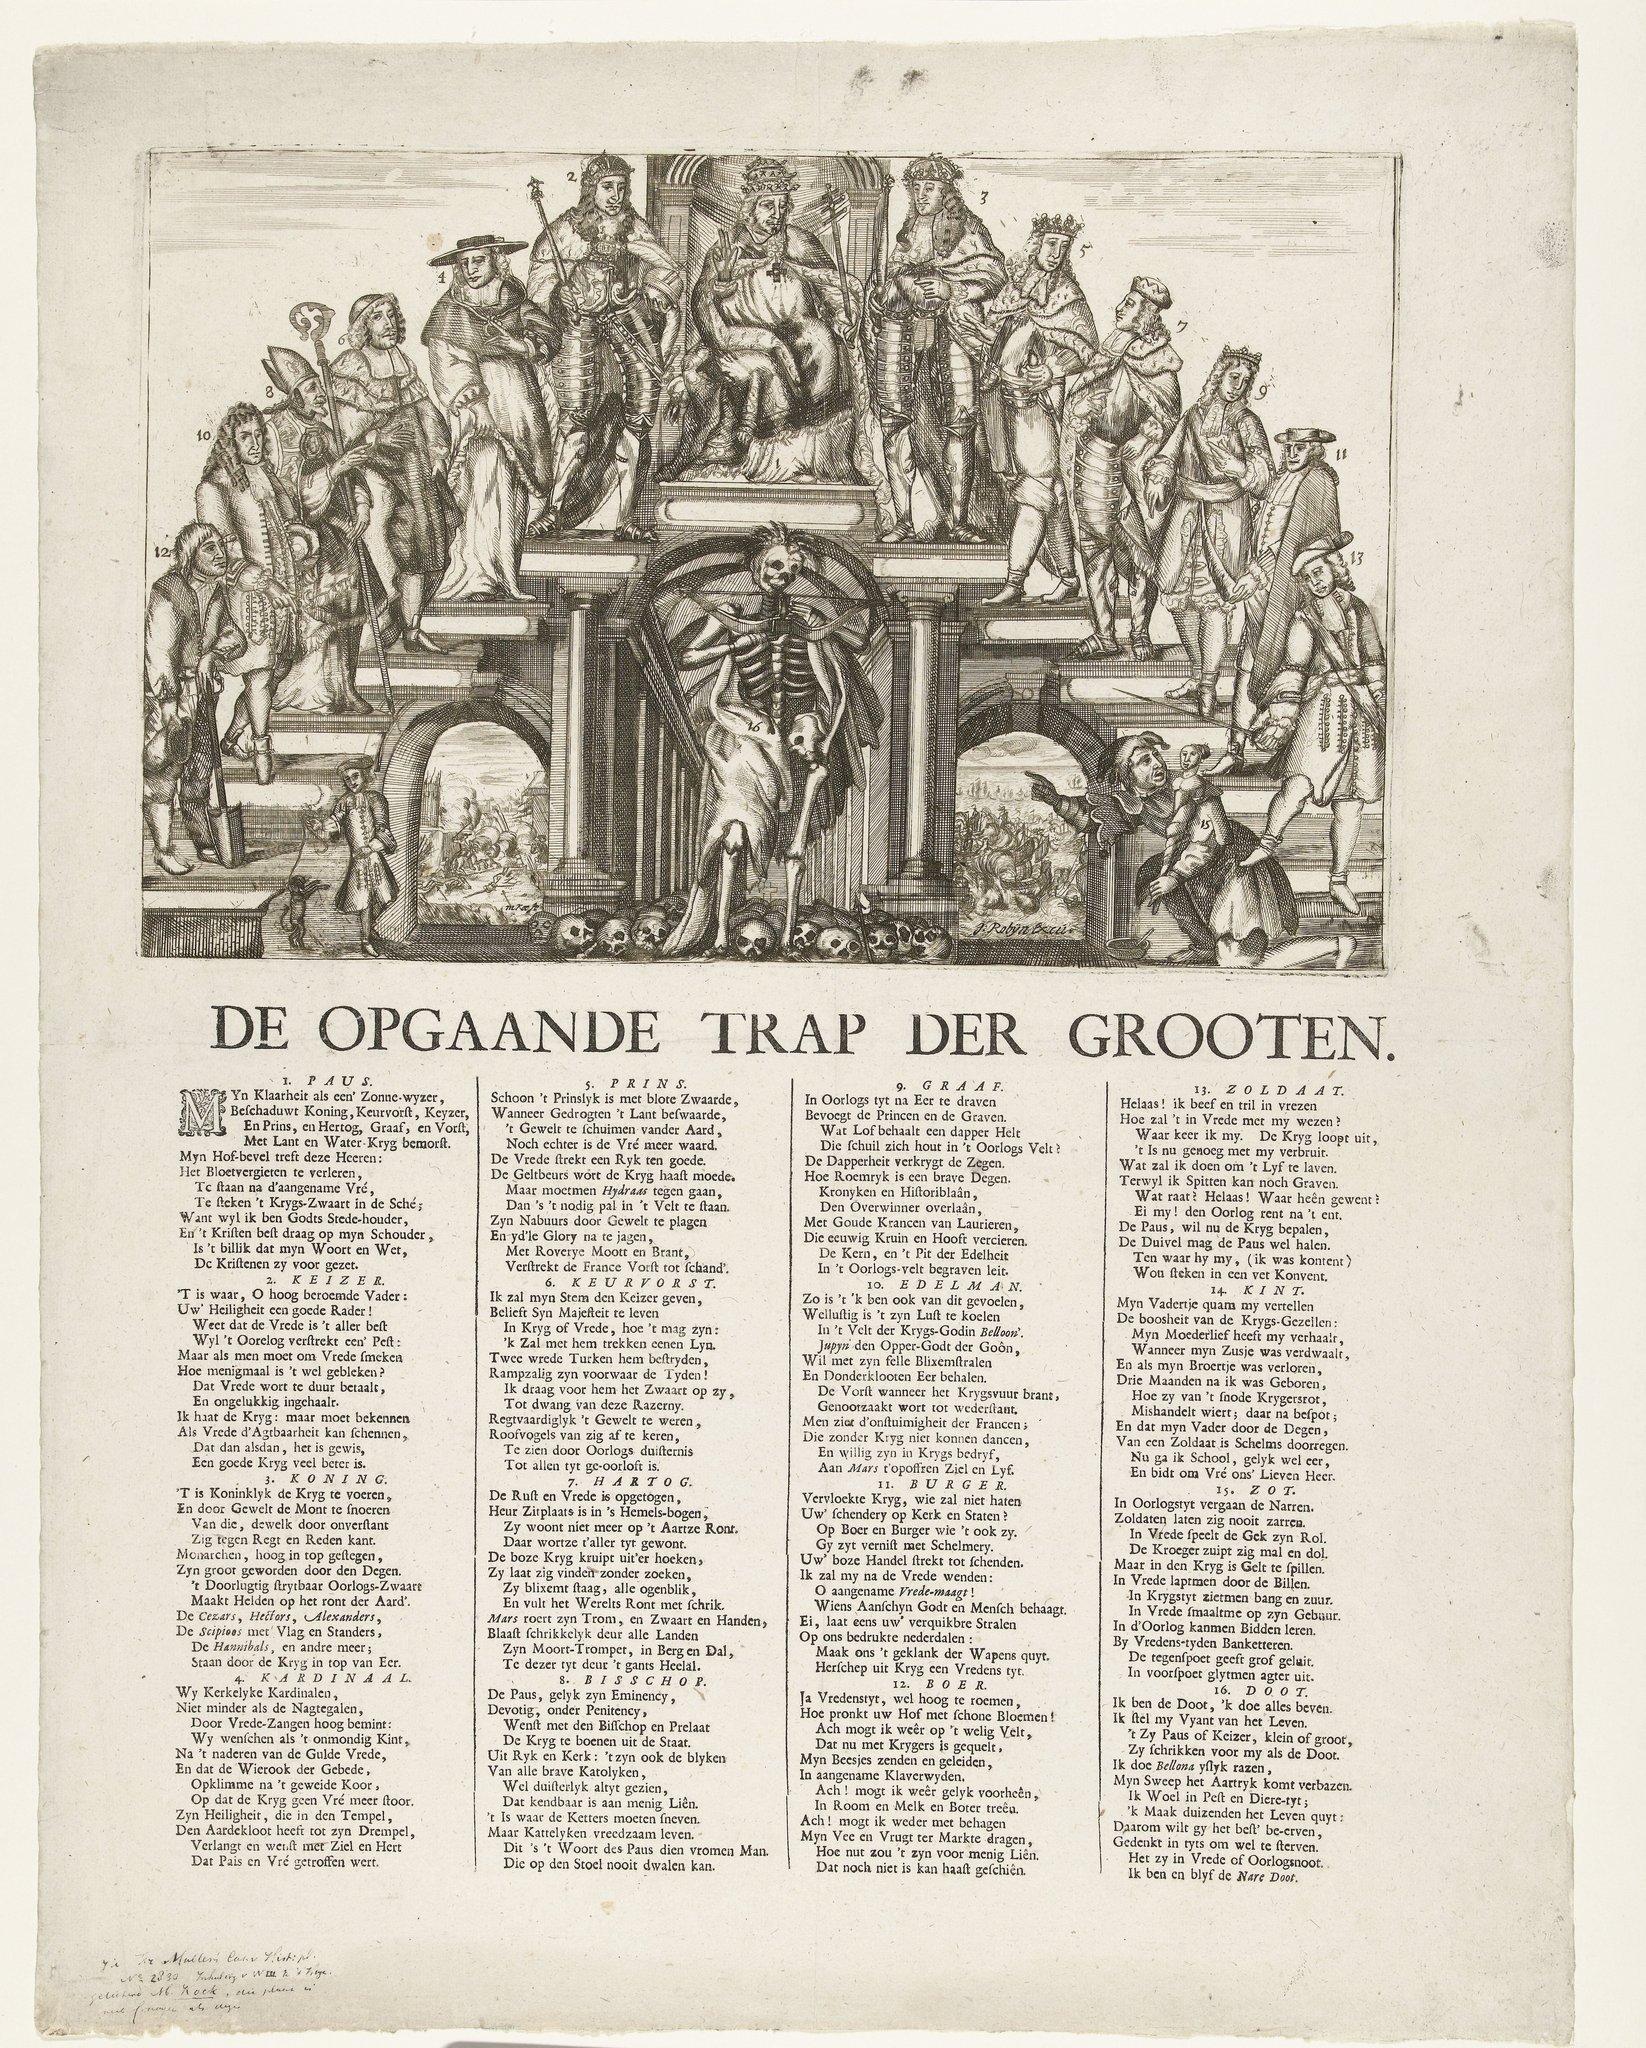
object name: print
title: De Opgaande Trap der Grooten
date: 1690-1710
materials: paper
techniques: engraving, etching, letterpress printing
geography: northern netherlands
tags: death dancing with more than one human being, death as skeleton, the ages of man represented by a staircase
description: Trap der groten. Opgaande trap waarop de wereldlijke en geestelijke rangen en standen staan, vanaf het spelend kind, boer en burger onderaan tot aan de paus, keizer en koning bovenaan. In het midden onderaan richt de Dood zijn kruisboog op de beschouwer, rechts een nar. Tussen de bogen doorkijkjes op oorlog ter land en ter zee. Op het blad onder de plaat verzen behorend bij de rangen en standen genummerd 1-16 in het Nederlands.